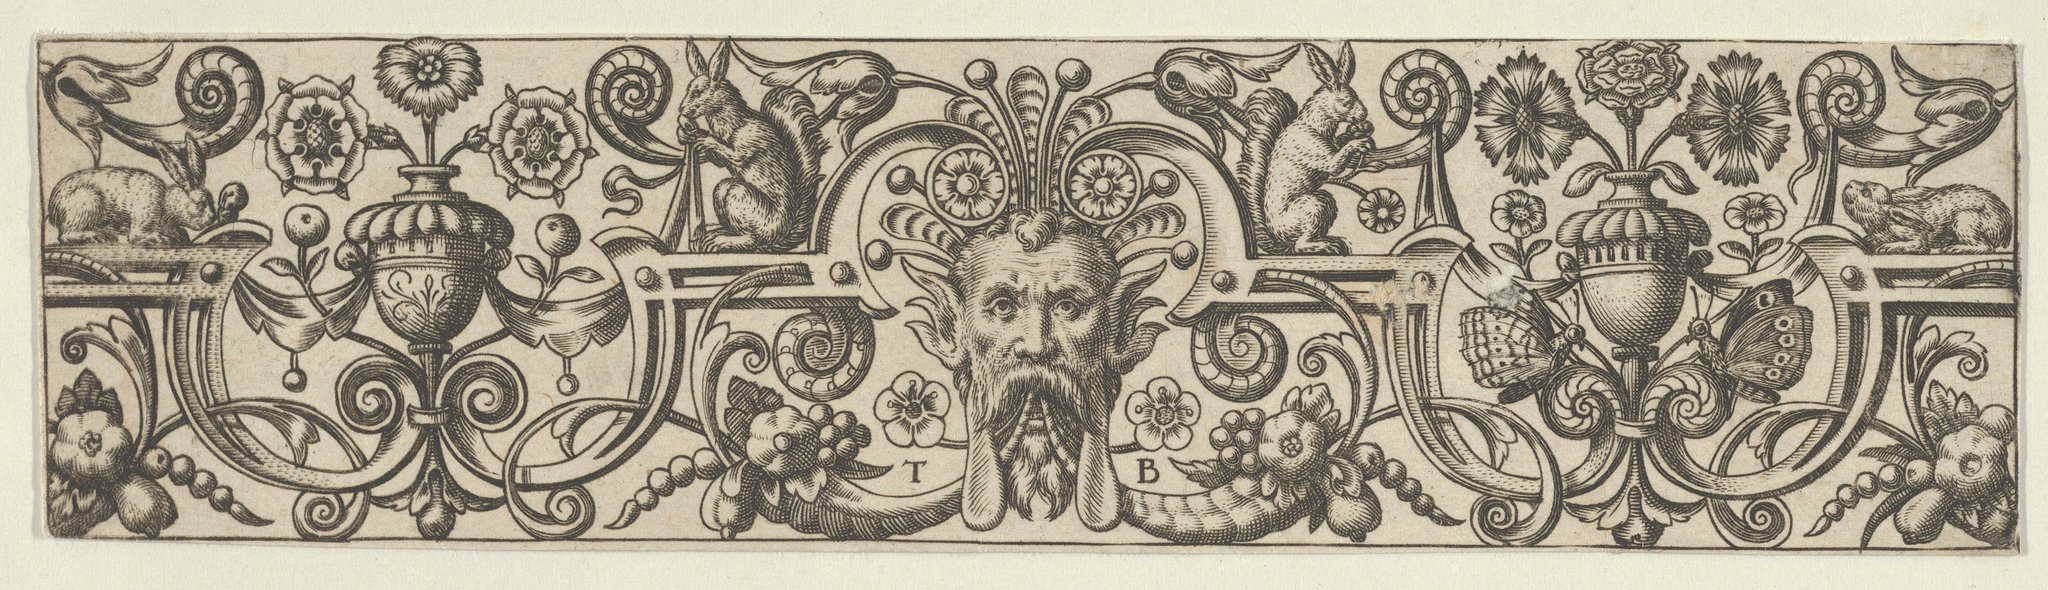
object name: print ornament architecture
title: Frieze with a Bearded Mask Wearing a Headdress of Tendrils and Strapwork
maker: theodor de bry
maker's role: artist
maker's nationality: netherlandish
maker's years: 1528-1598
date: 1590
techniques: engraving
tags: masks,squirrels,flowers